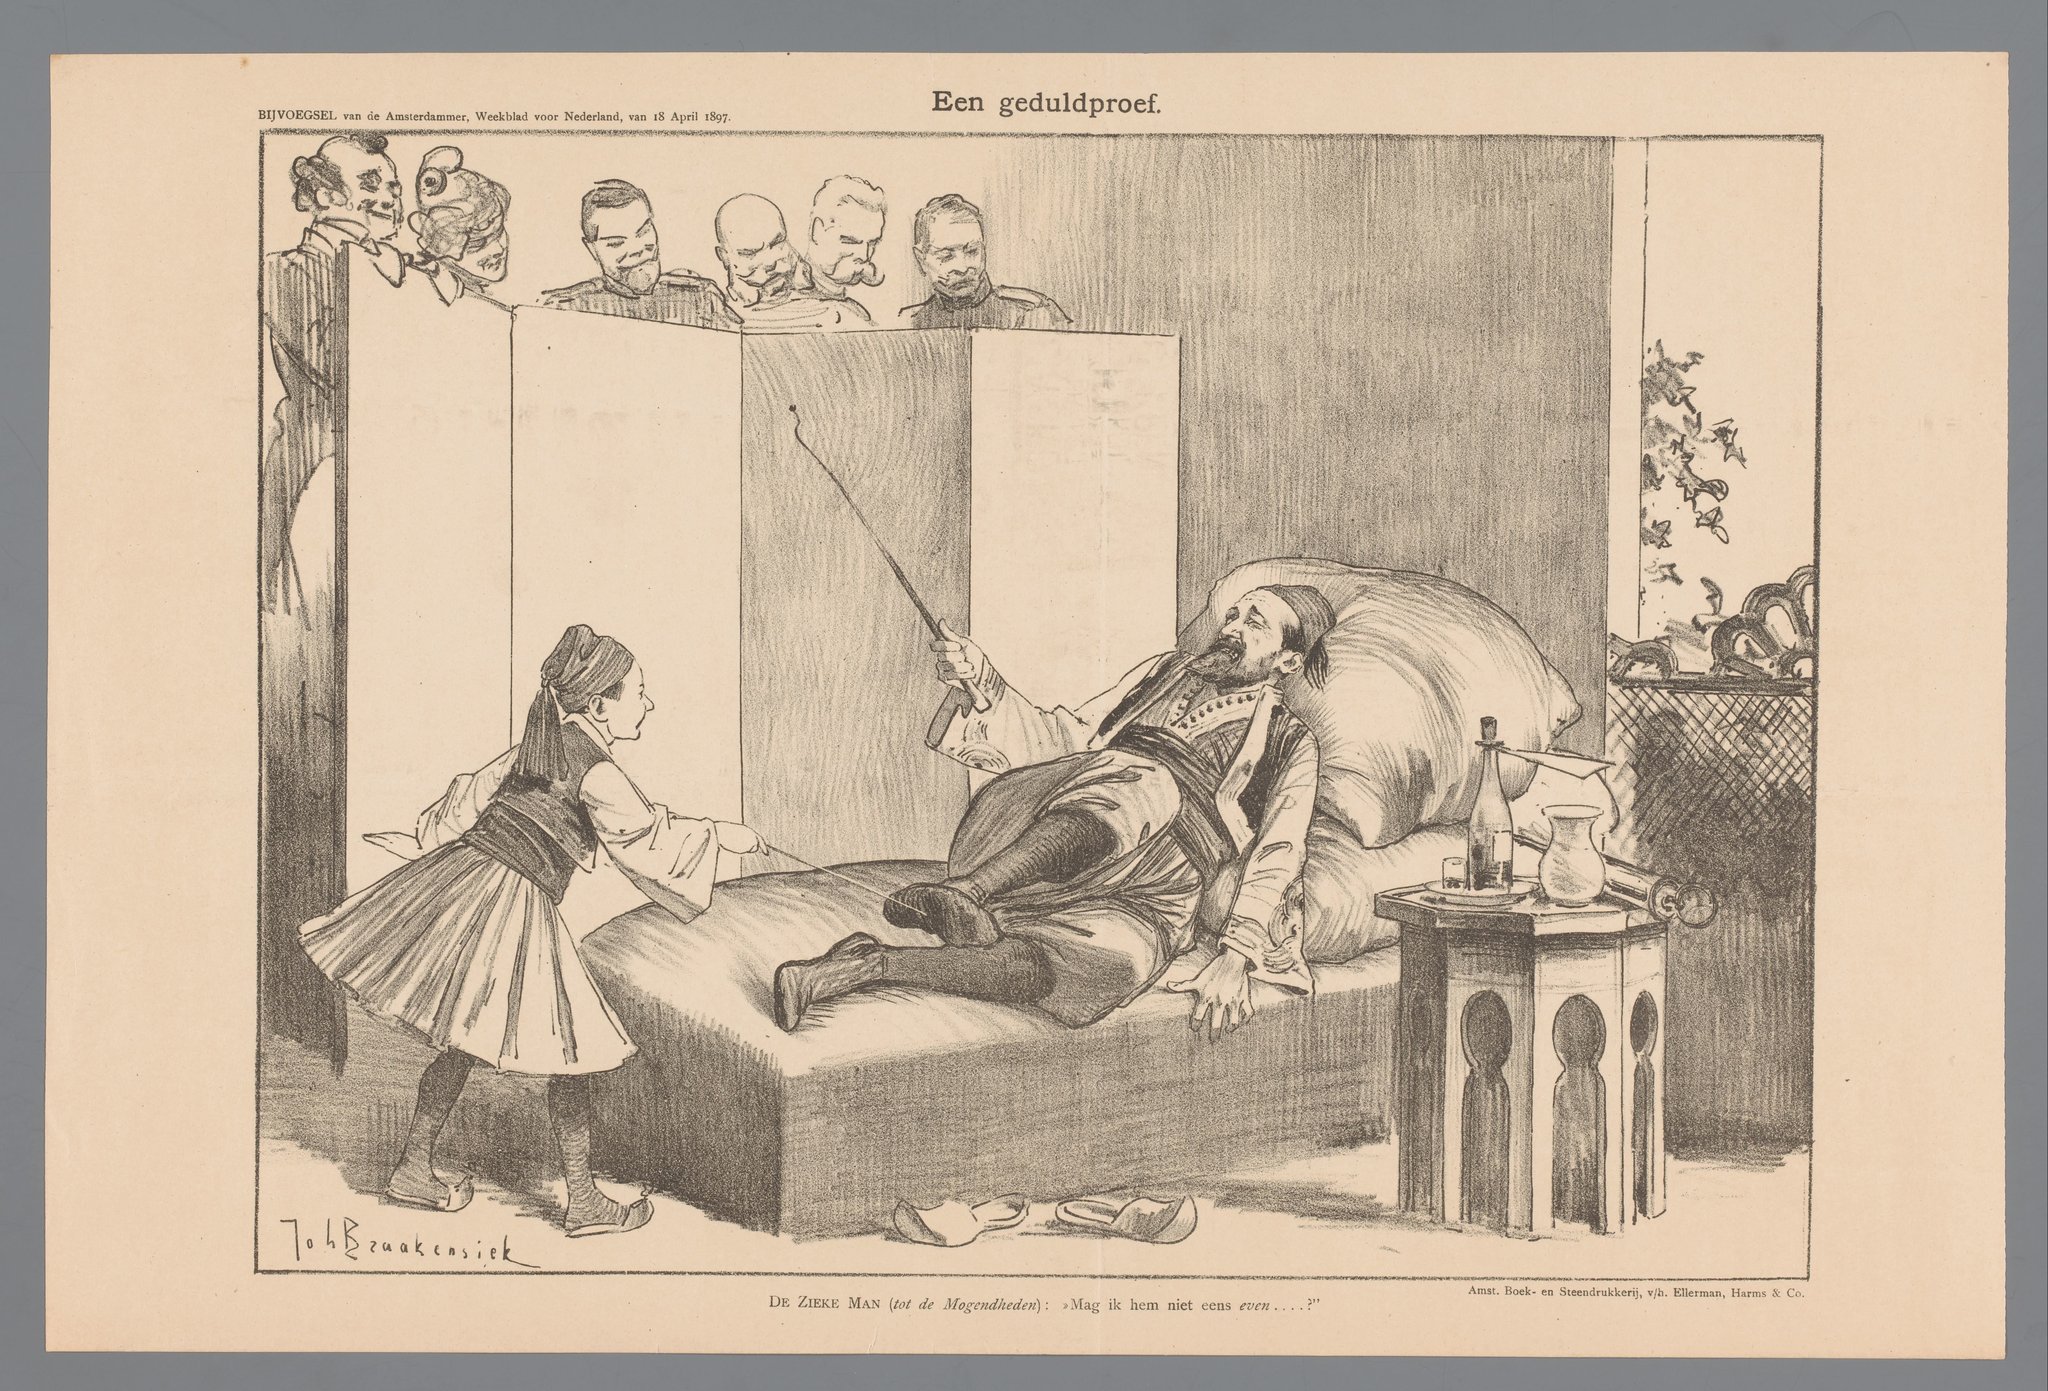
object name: cartoon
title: Een geduldproef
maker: johan braakensiek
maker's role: draughtsman, print maker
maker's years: 1858-1940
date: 1897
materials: paper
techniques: lithograph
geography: amsterdam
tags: personifications of countries, nations, states, districts, etc., sick-bed, political caricatures and satires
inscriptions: date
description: Prent uit het bijvoegsel van: De Amsterdammer. Weekblad voor Nederland, 18 april 1897.